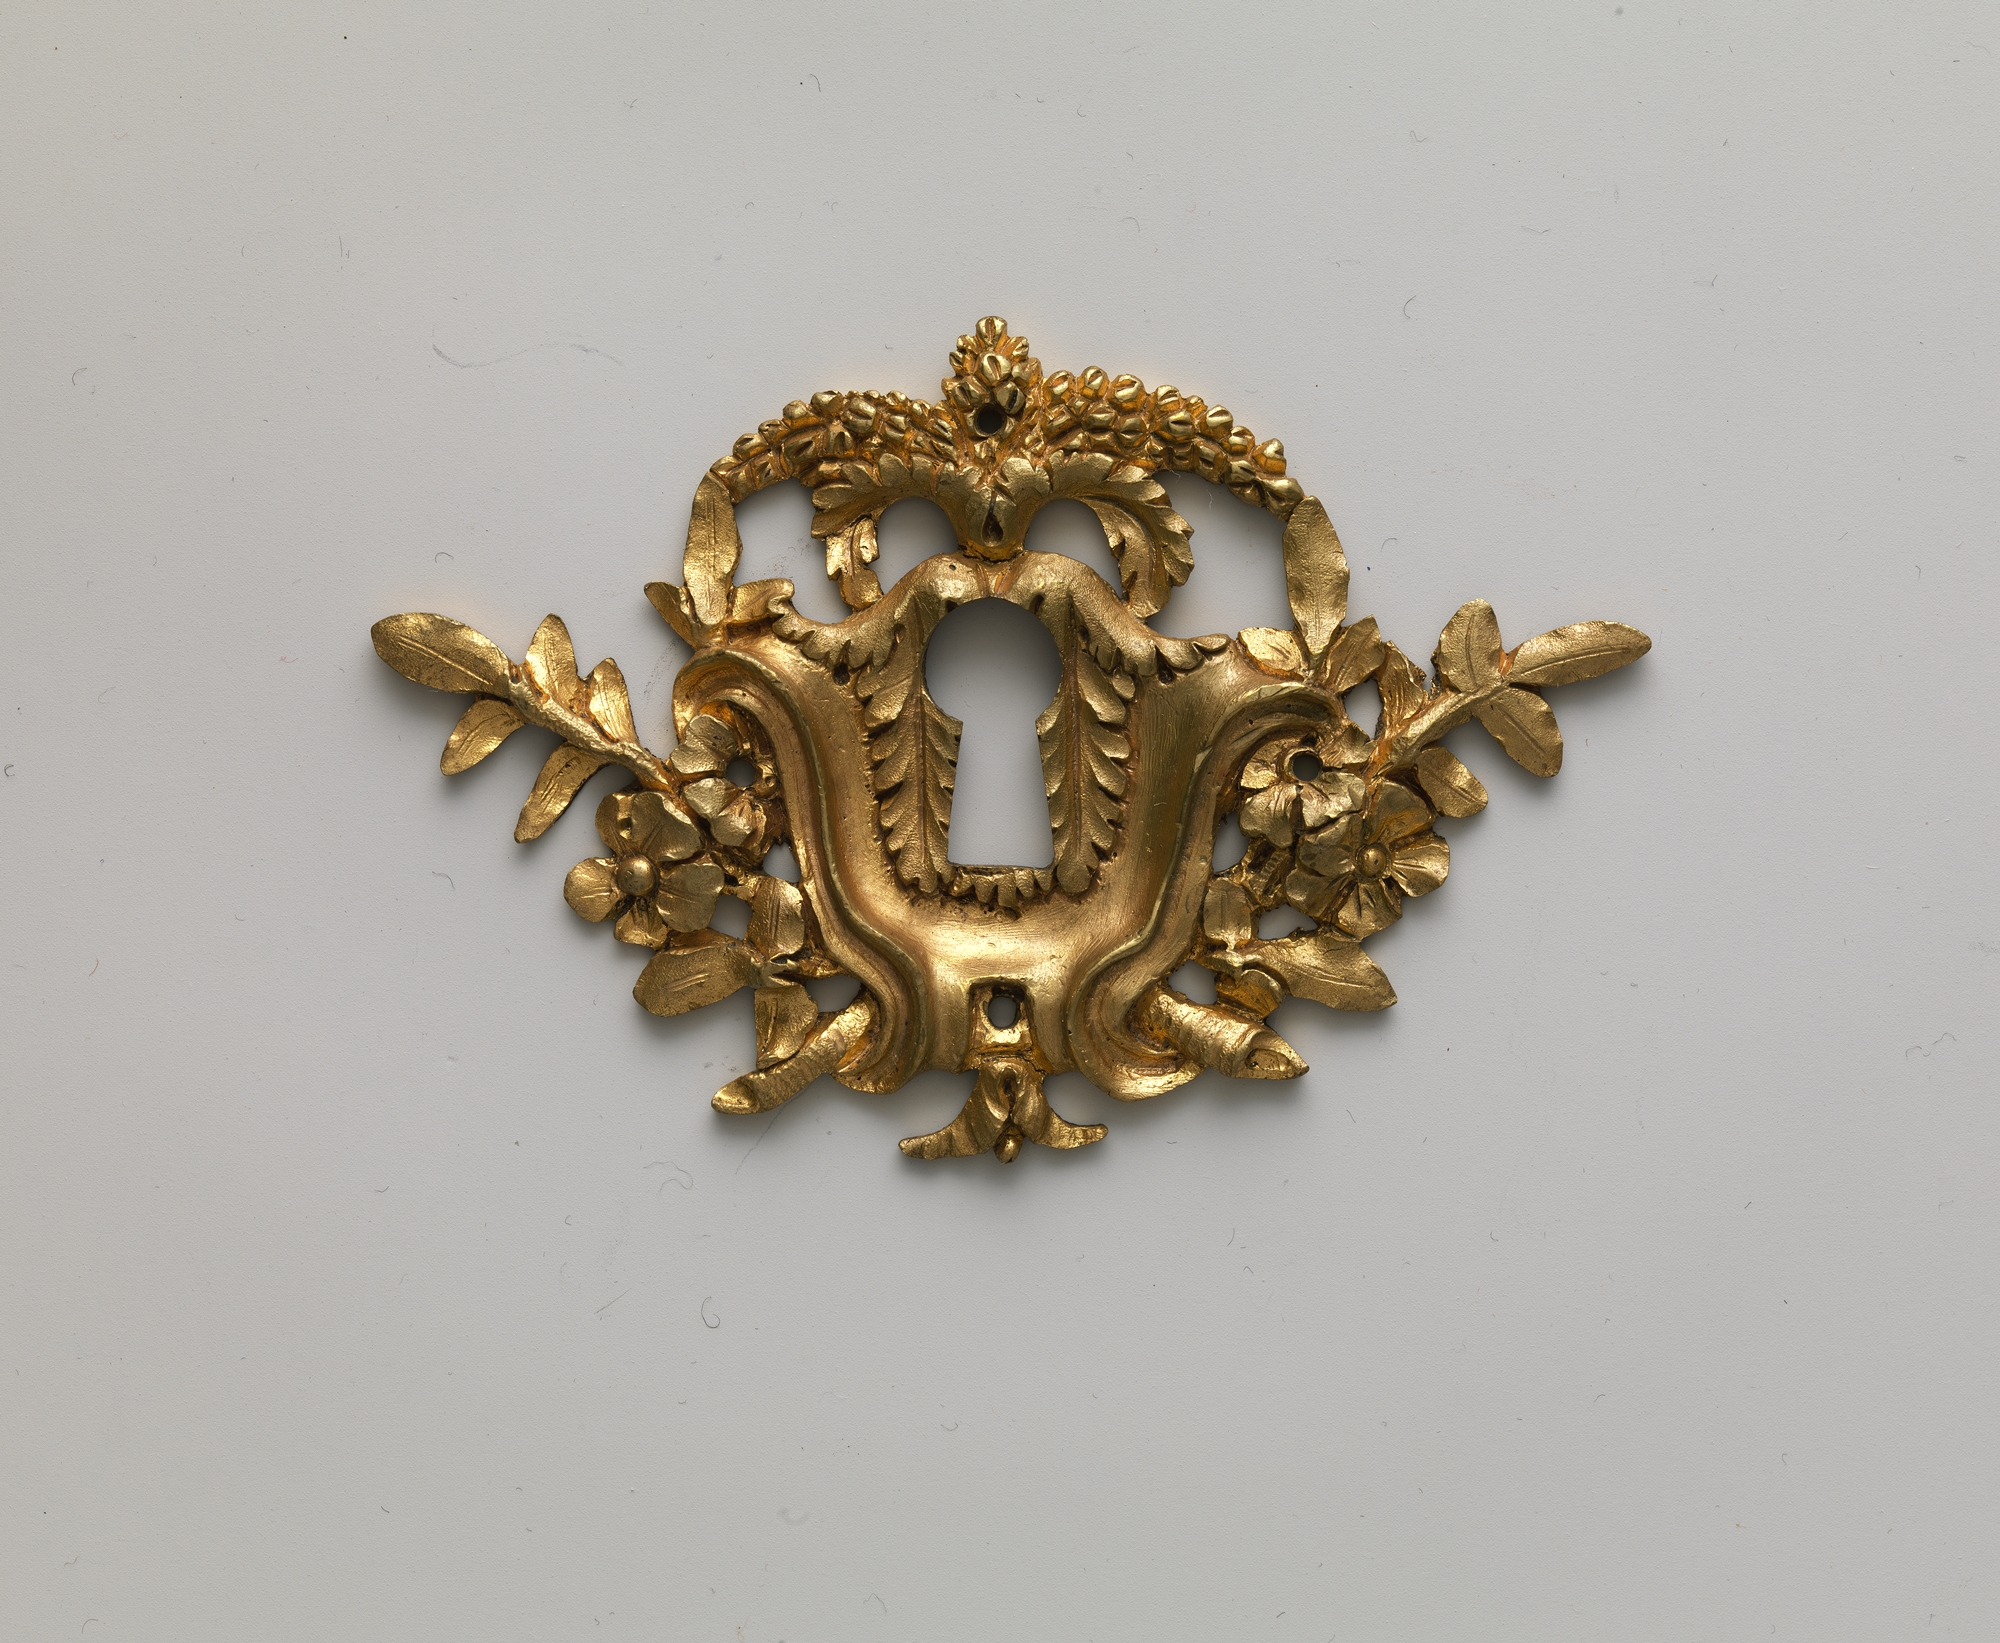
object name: keyhole escutcheon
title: Pair of keyhole escutcheons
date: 1701-1800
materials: gilt bronze